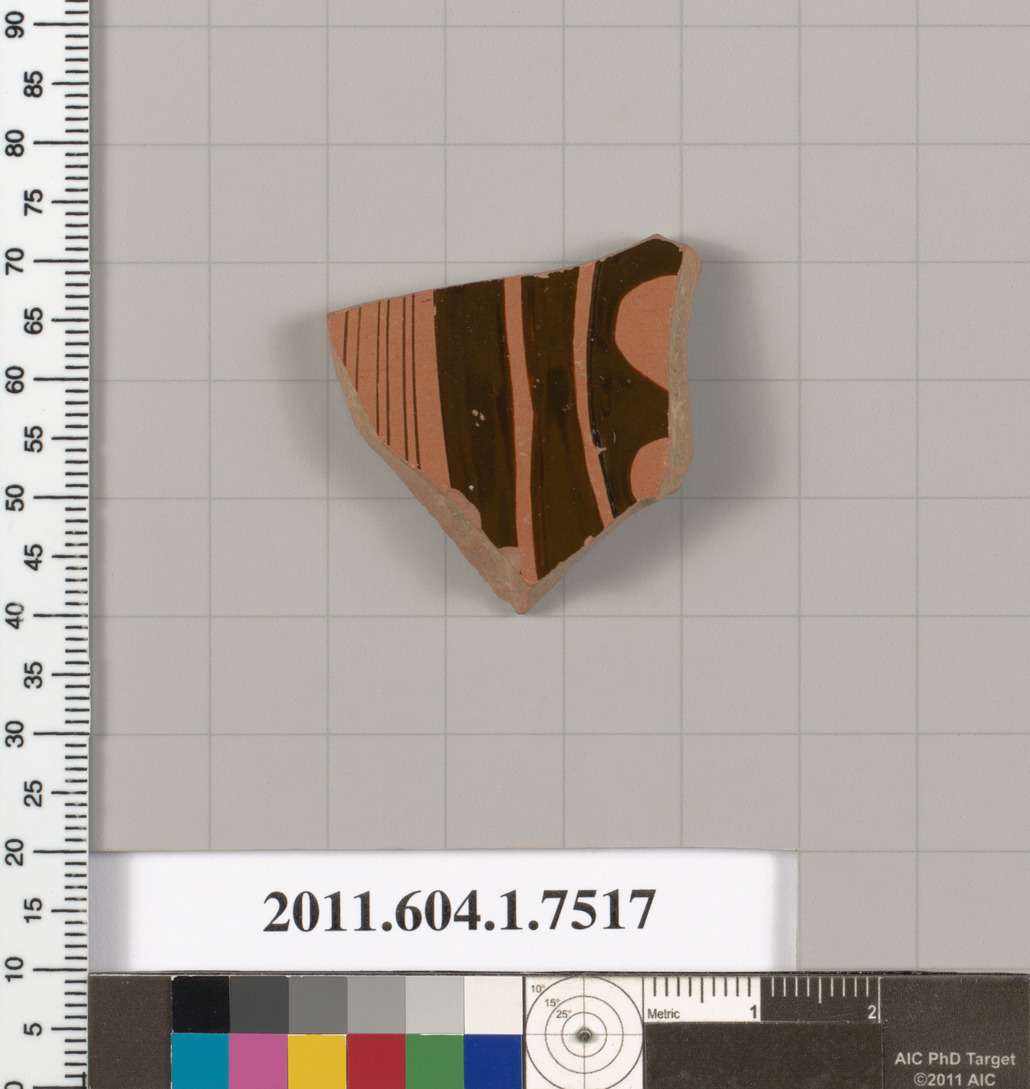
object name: kylix fragment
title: Terracotta fragment of a kylix (drinking cup)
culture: greek, attic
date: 460-450 BCE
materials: terracotta